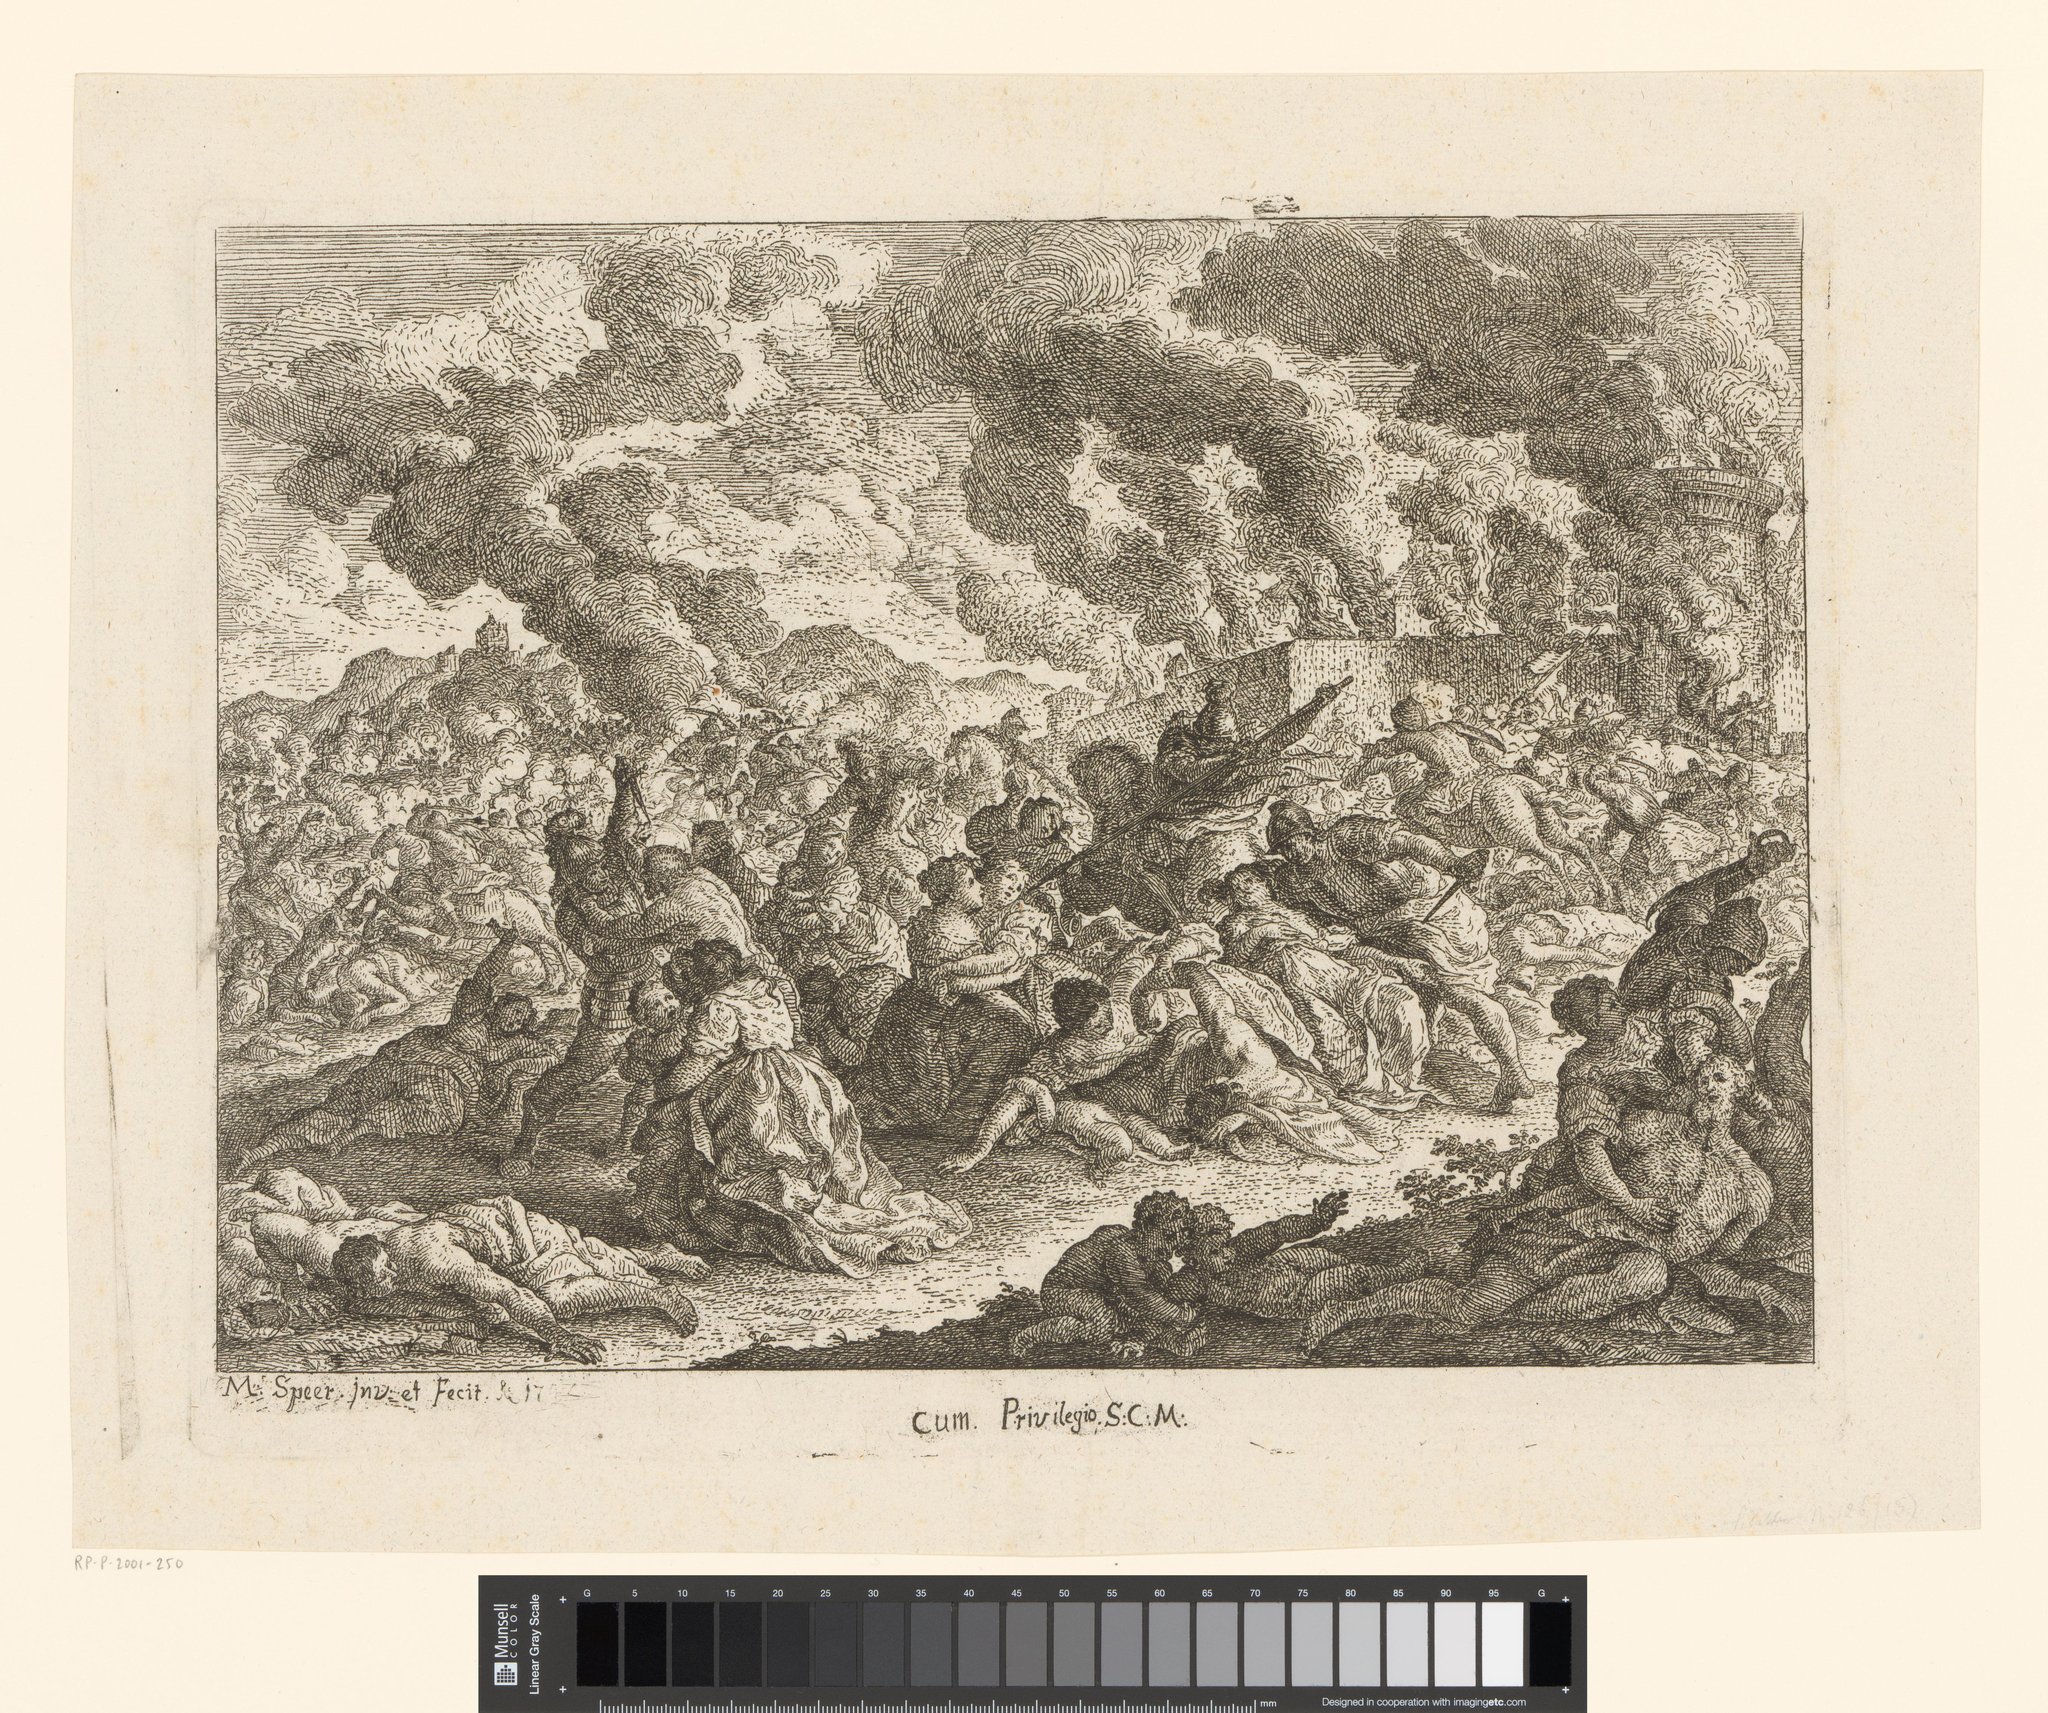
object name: print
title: Plundering van een stad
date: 1742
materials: paper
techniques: etching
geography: regensburg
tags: plundering ~ soldiers, setting on fire (of conquered city)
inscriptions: collector's mark: Lugt 2228